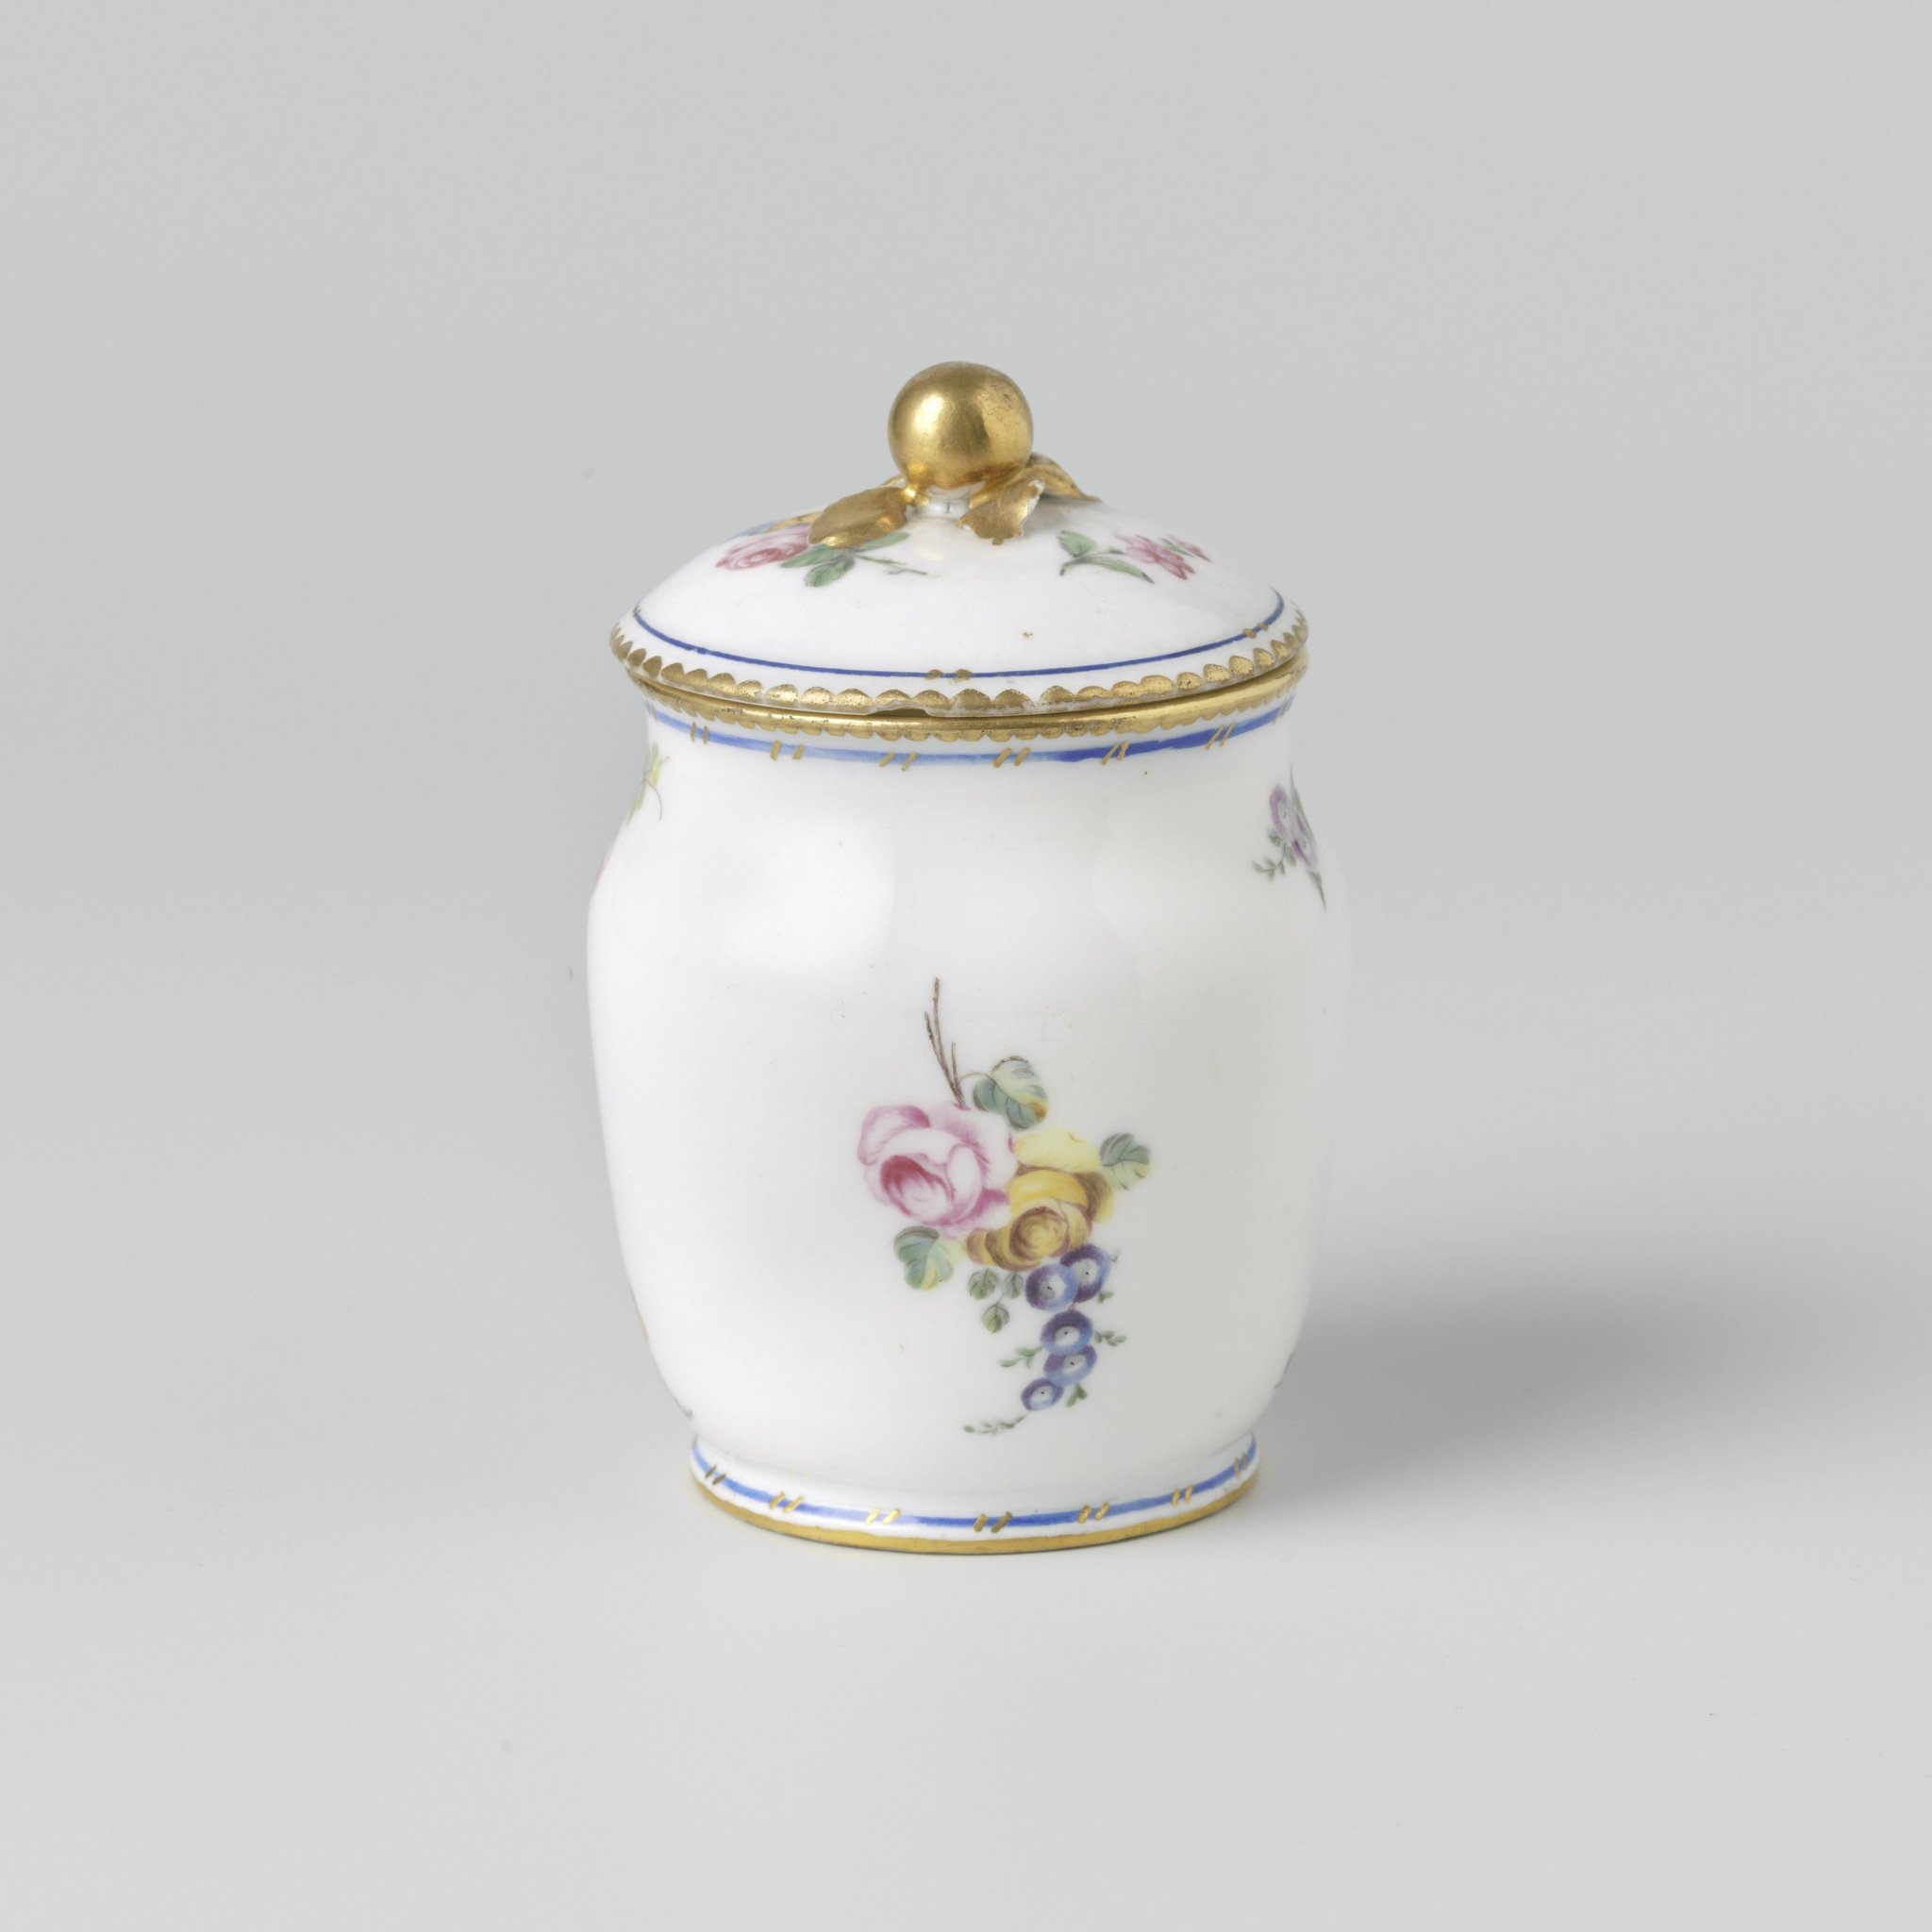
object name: pot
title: Covered pot with bouquets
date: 1758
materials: glaze, gold, paint, porcelain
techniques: firing, forming, gilding, turning, vitrification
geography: sèvres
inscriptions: mark: ‘dubbele L/ jaarnummer E/ +’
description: Dekselpot van porselein met een licht eivormig lichaam, beschilderd op het glazuur in blauw, rood, roze, groen, geel, paars, zwart en goud. De buik is versierd met verschillende boeketten en strooibloemen. De voet en rand met een blauwe lijn, onderbroken door telkens tweemaal een schuin gouden streepje. Op de rand boven deze lijn een gouden band van halve bollen. De deksel met dezelfde decoratie; dekselknop in de vorm van een fruittak bedekt met goud. Gemerkt op de onderzijde met de dubbele L met jaarletter E, waarboven een +.